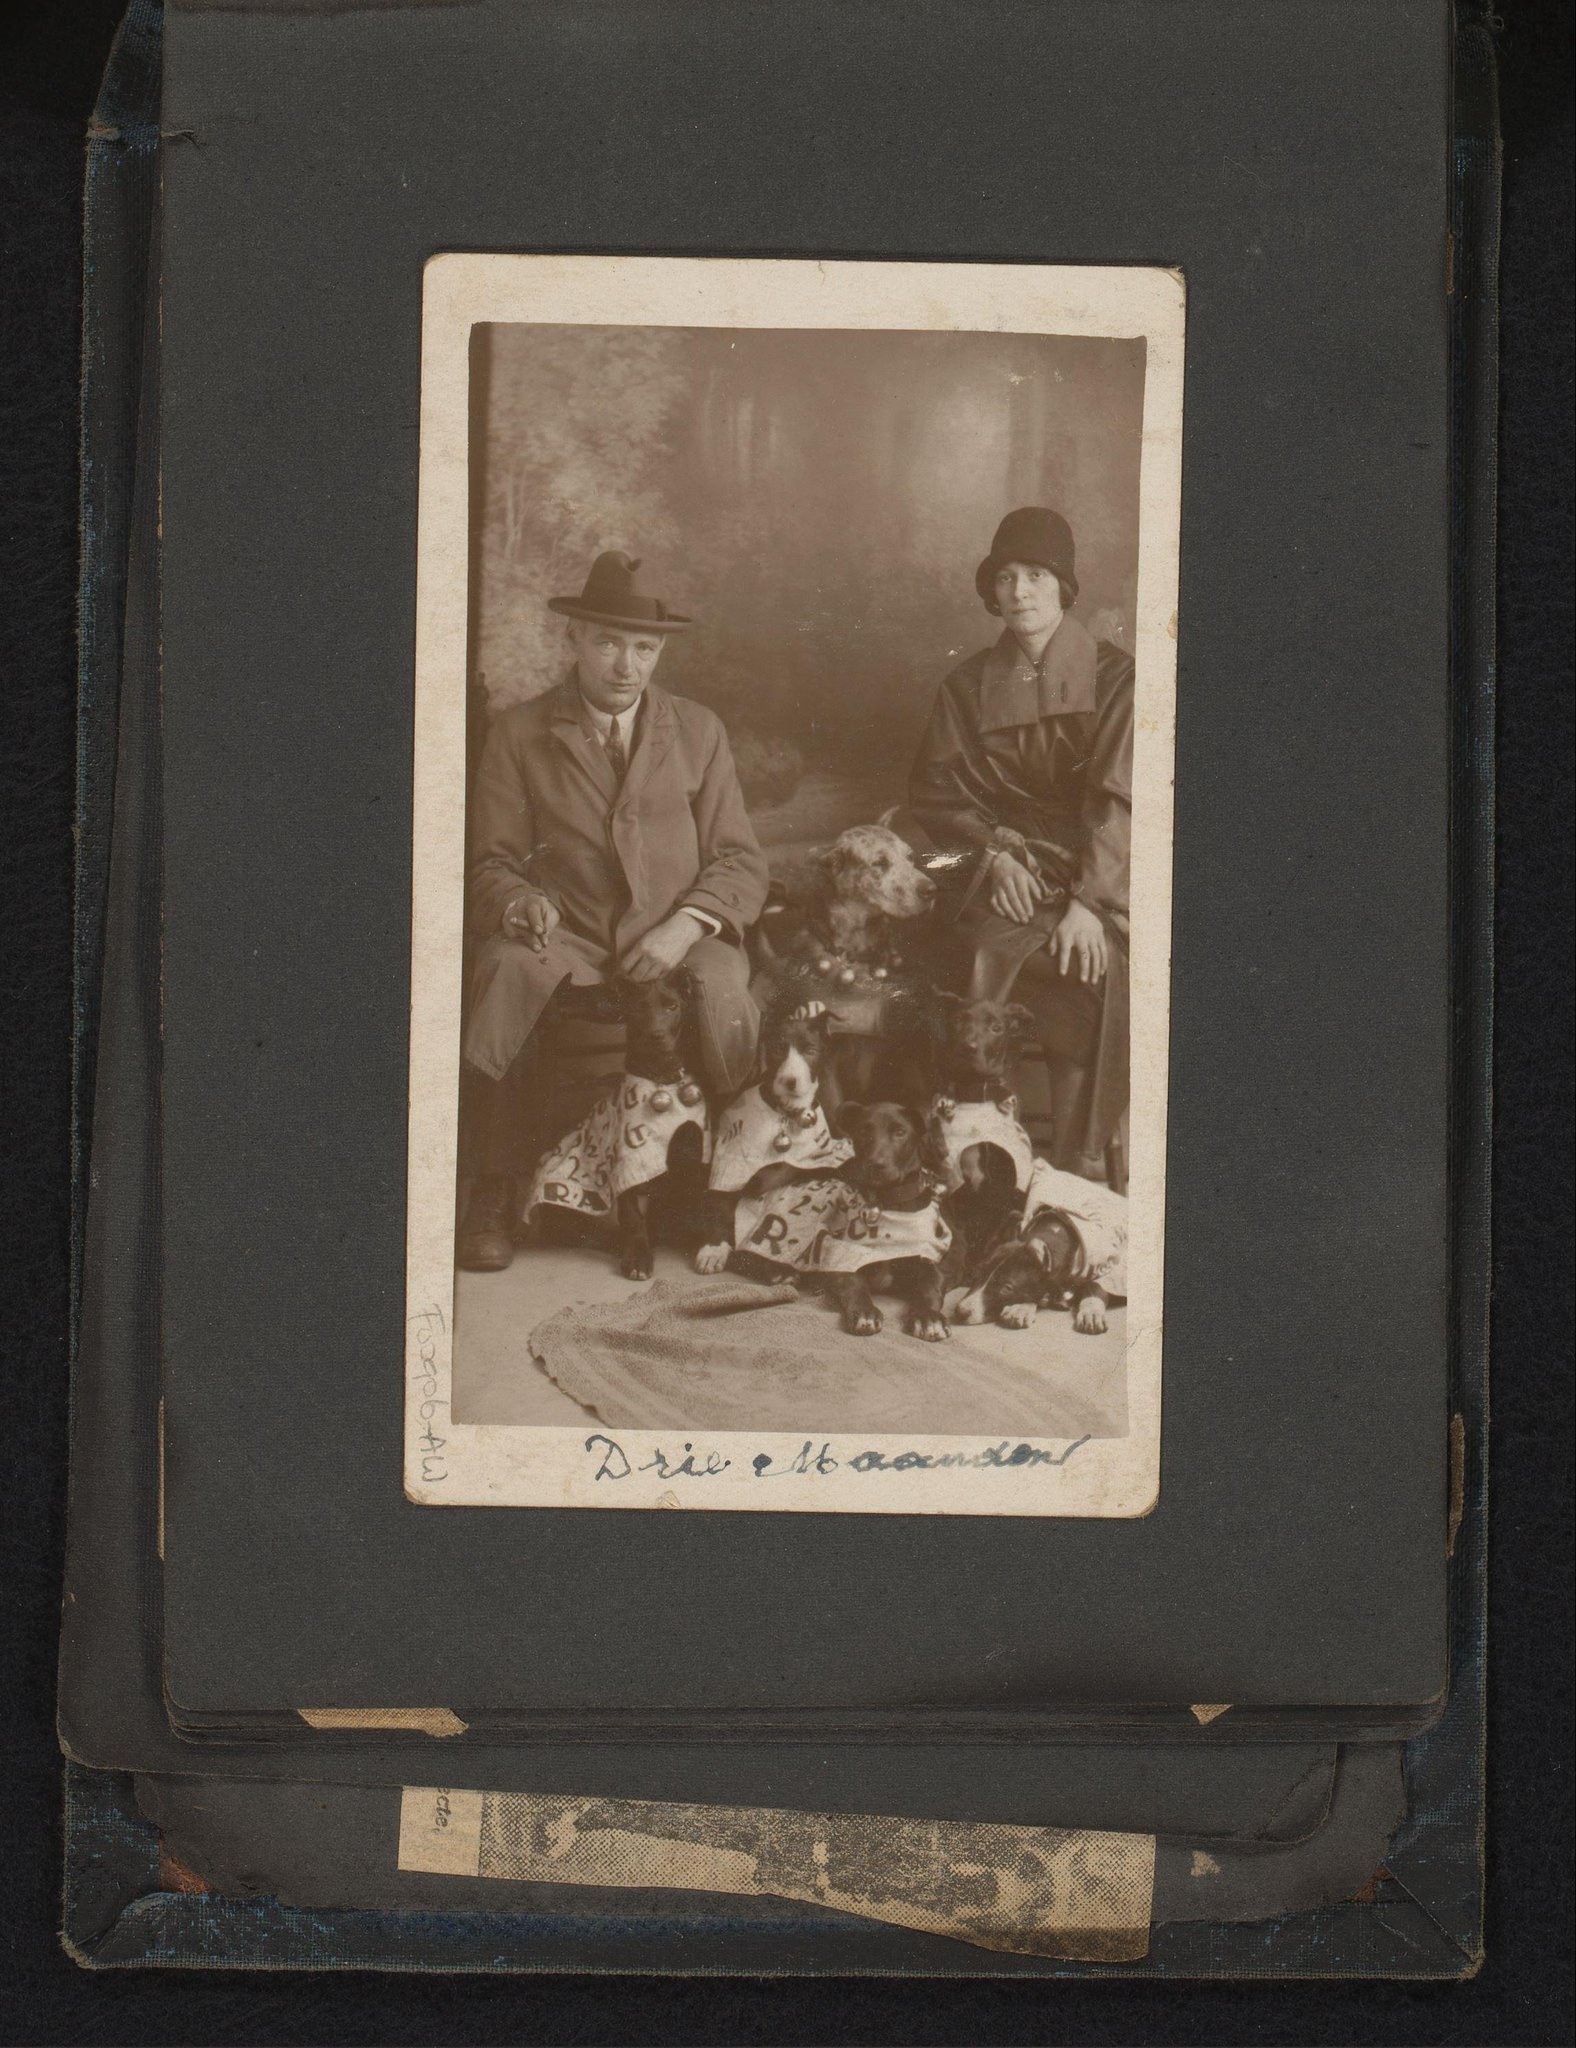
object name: album leaf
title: Portret van de poppendokter met vrouw en honden met reclameteksten op de rug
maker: Anonymous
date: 1930-1940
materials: photographic support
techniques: gelatin silver print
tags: advertising, historical persons, dog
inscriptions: annotation: ‘Drie [...]’